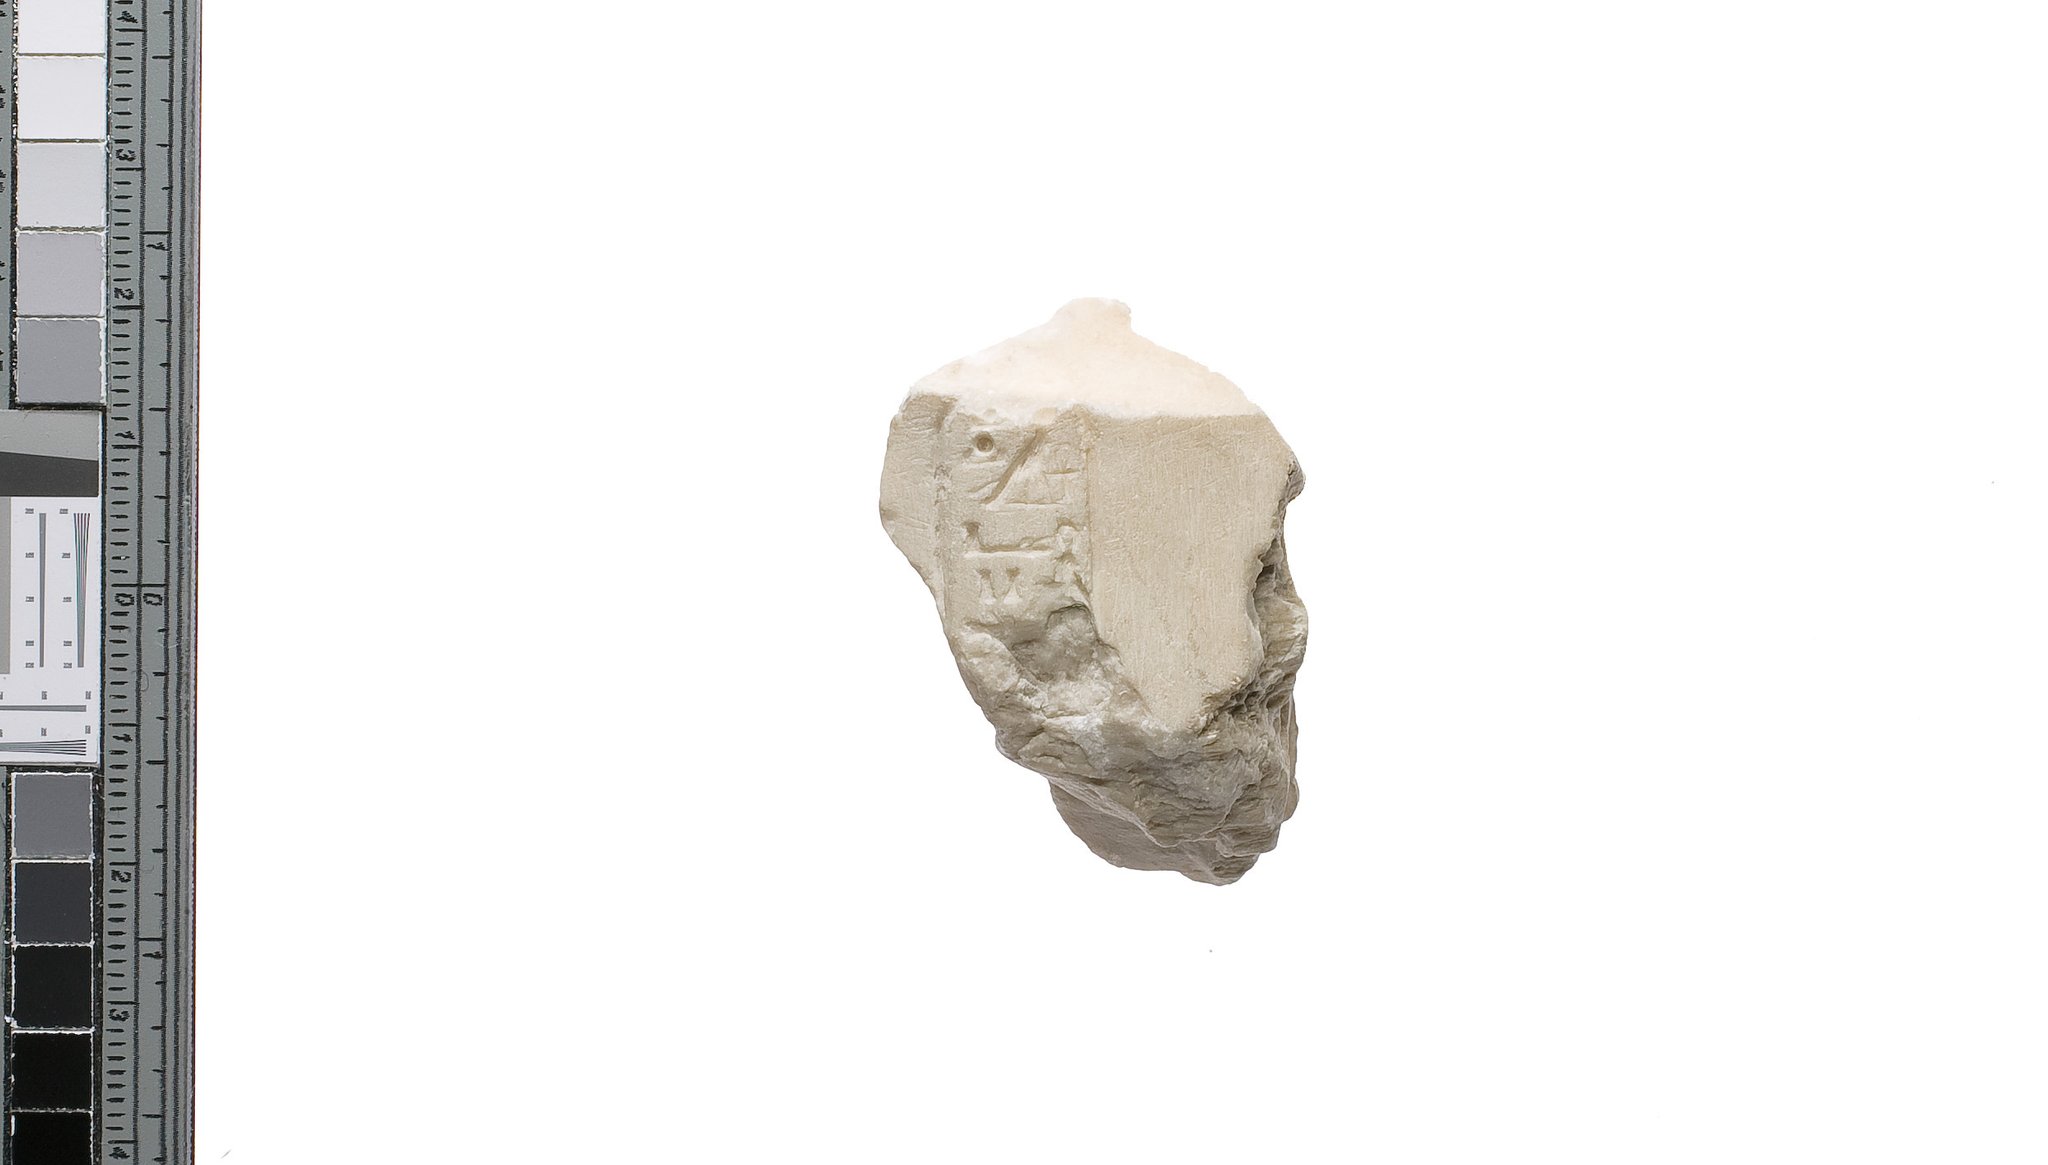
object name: cobra hood, aten inscription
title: Cobra hood with Aten inscription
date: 1353-1336 BCE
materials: limestone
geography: egypt